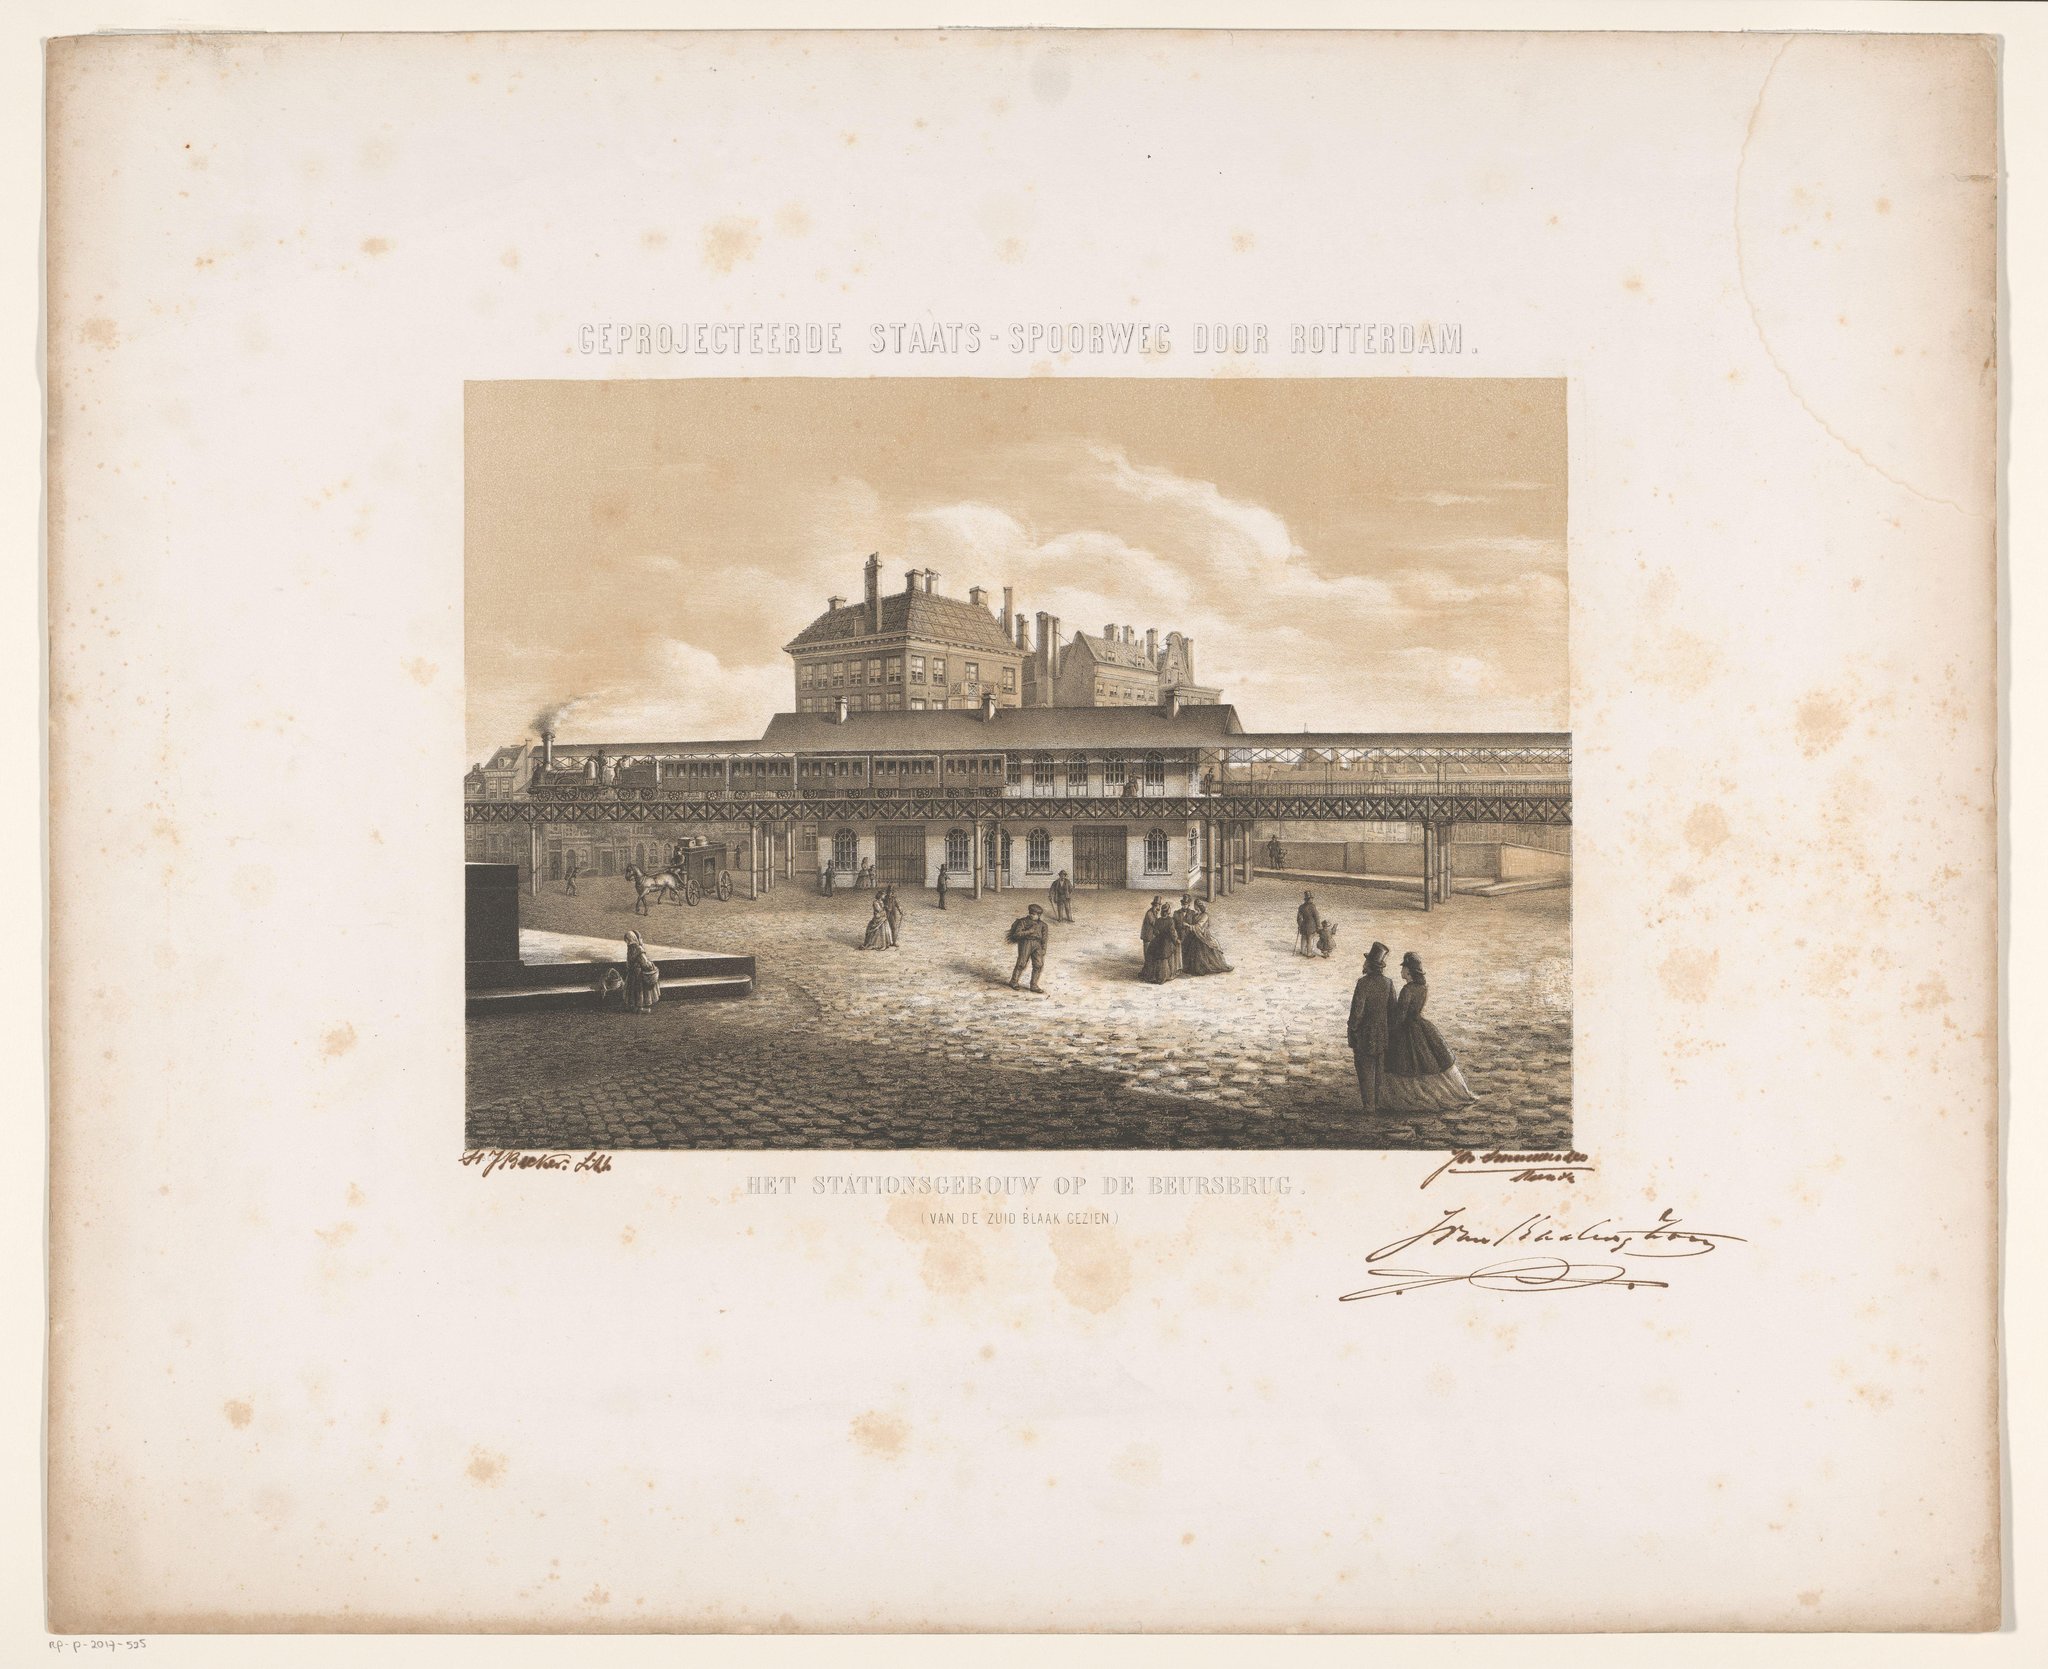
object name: print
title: Het stationsgebouw op de Beursbrug (van de Zuid Blaak gezien)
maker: f.j. becker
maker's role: print maker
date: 1864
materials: paper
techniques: tone lithography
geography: rotterdam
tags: station; shelter (railway, tramway), rotterdam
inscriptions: : ‘F.J. Becker lith J. Smulders steendr / J. van Baalen Zonen / uitgevers’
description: Maakt deel uit van een serie van zeven prenten.